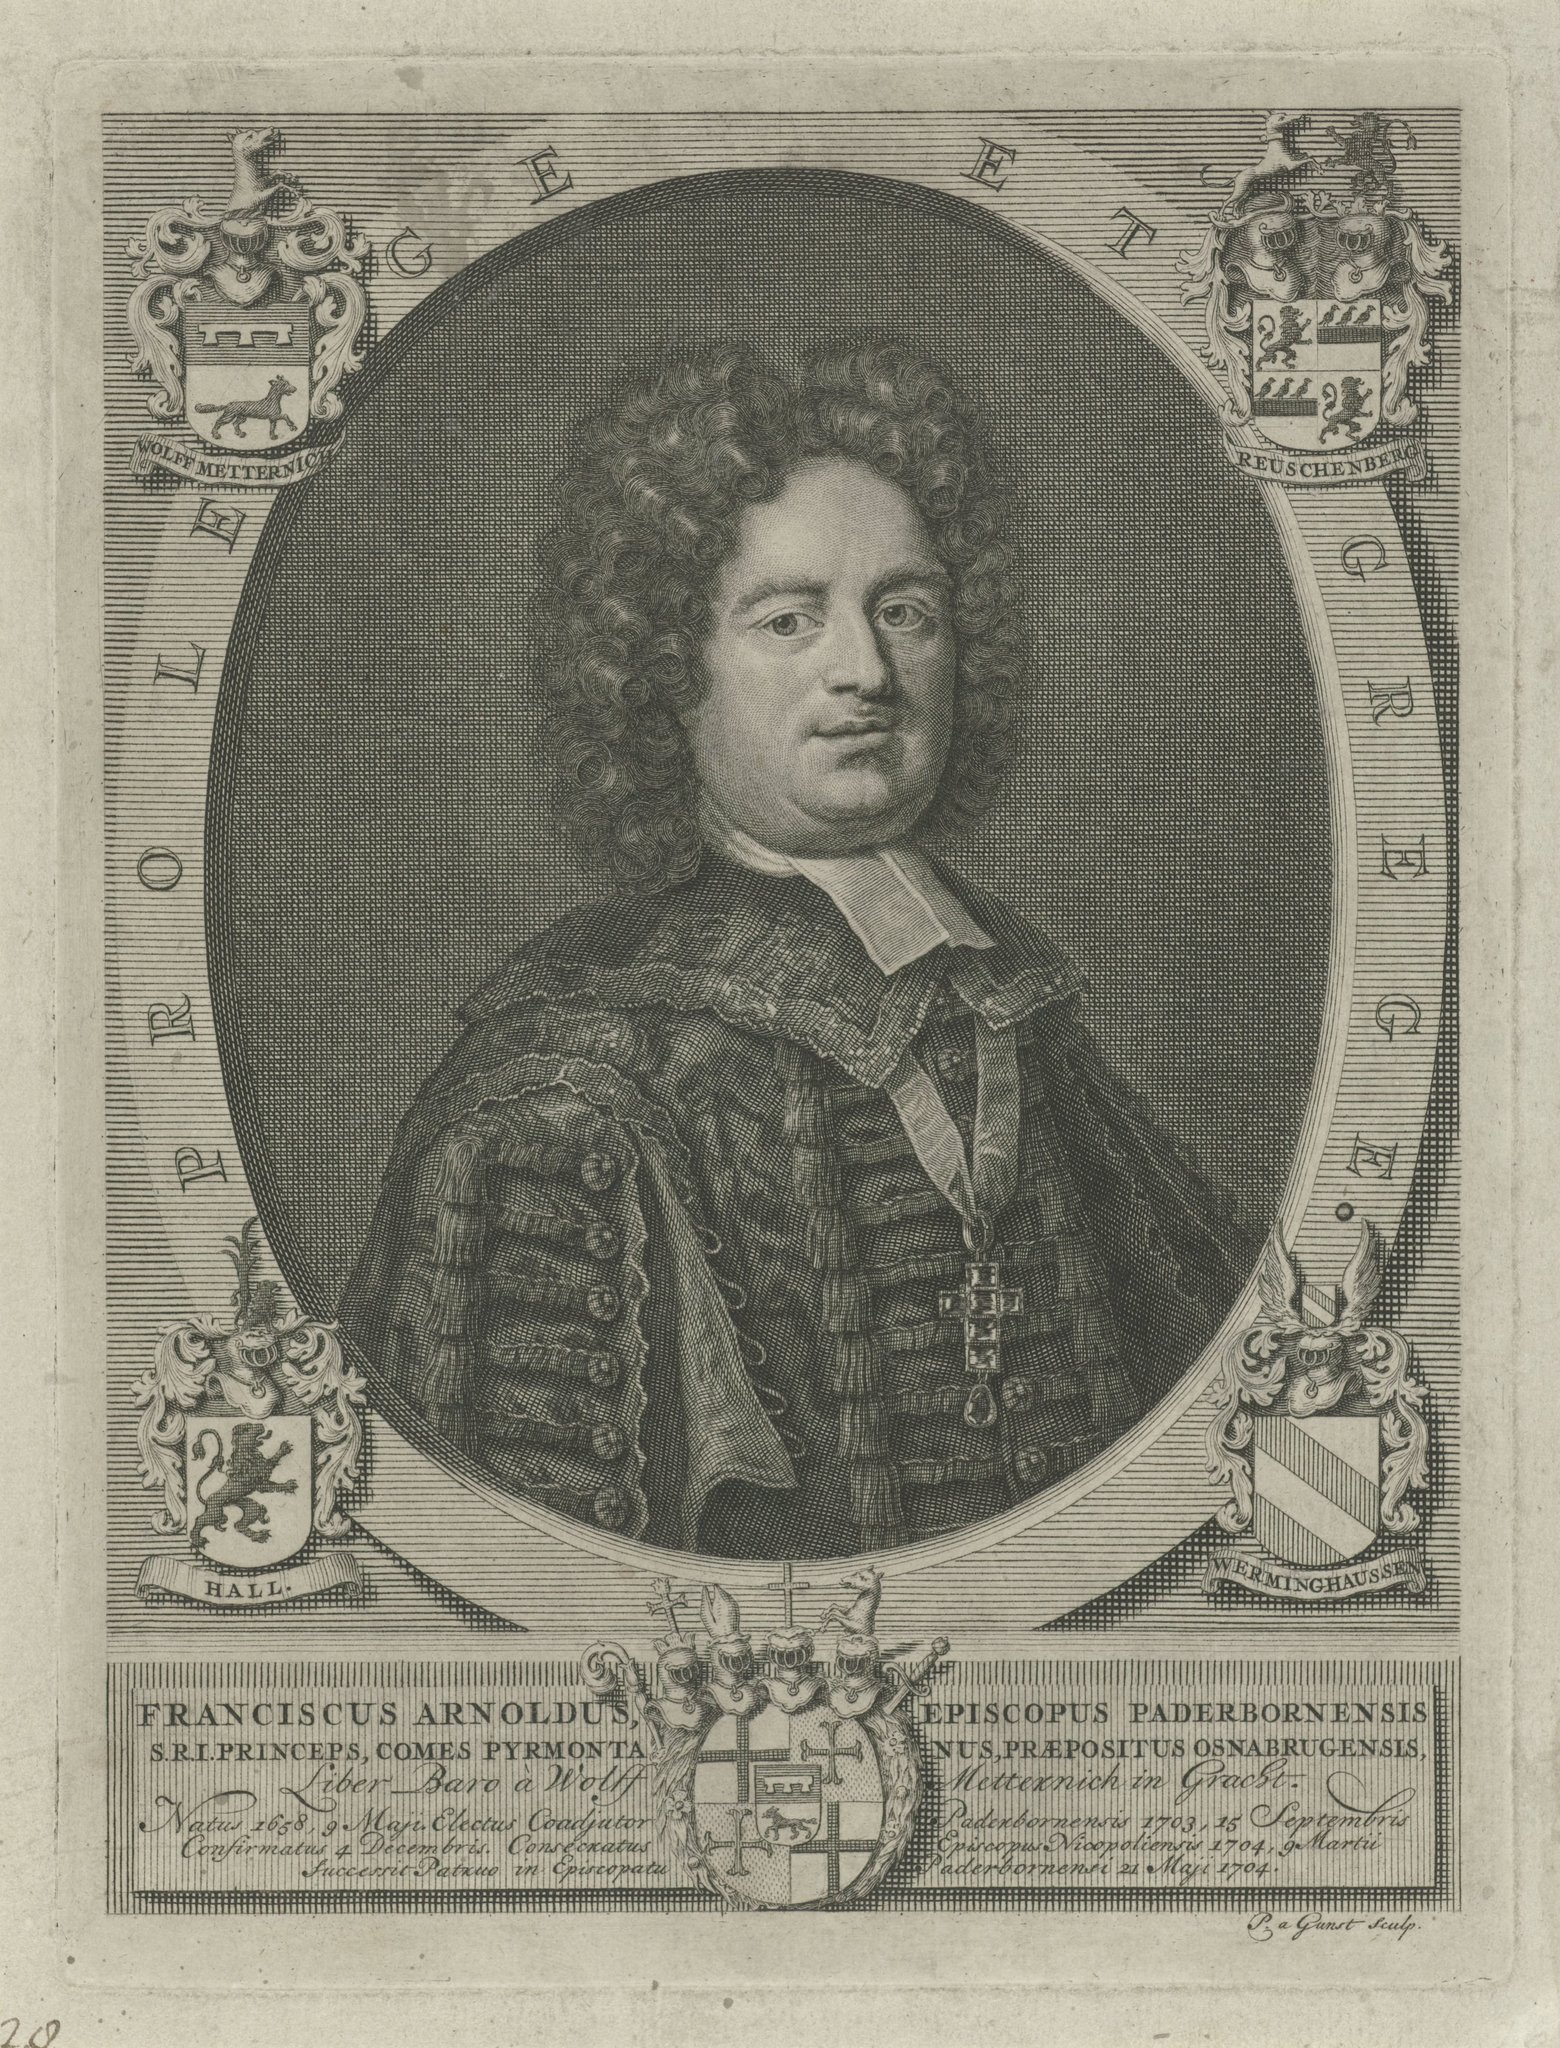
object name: print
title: Portret van Franz Arnold Wolff-Metternich zur Gracht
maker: pieter van gunst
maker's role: print maker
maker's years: 1658-1731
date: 1704-1707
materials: paper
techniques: engraving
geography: amsterdam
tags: bisschop, franz arnold wolff-metternich zur gracht (prins-bisschop van münster en paderborn)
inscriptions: collector's mark: Lugt 2228, number: ‘28’, collector's mark: Lugt 240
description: Franz Arnold Wolff-Metternich zur Gracht, prins-bisschop van Münster en Paderborn. De prent heeft een Latijns onderschrift over zijn leven. Rondom het portret de vier wapenschilden van zijn familie.